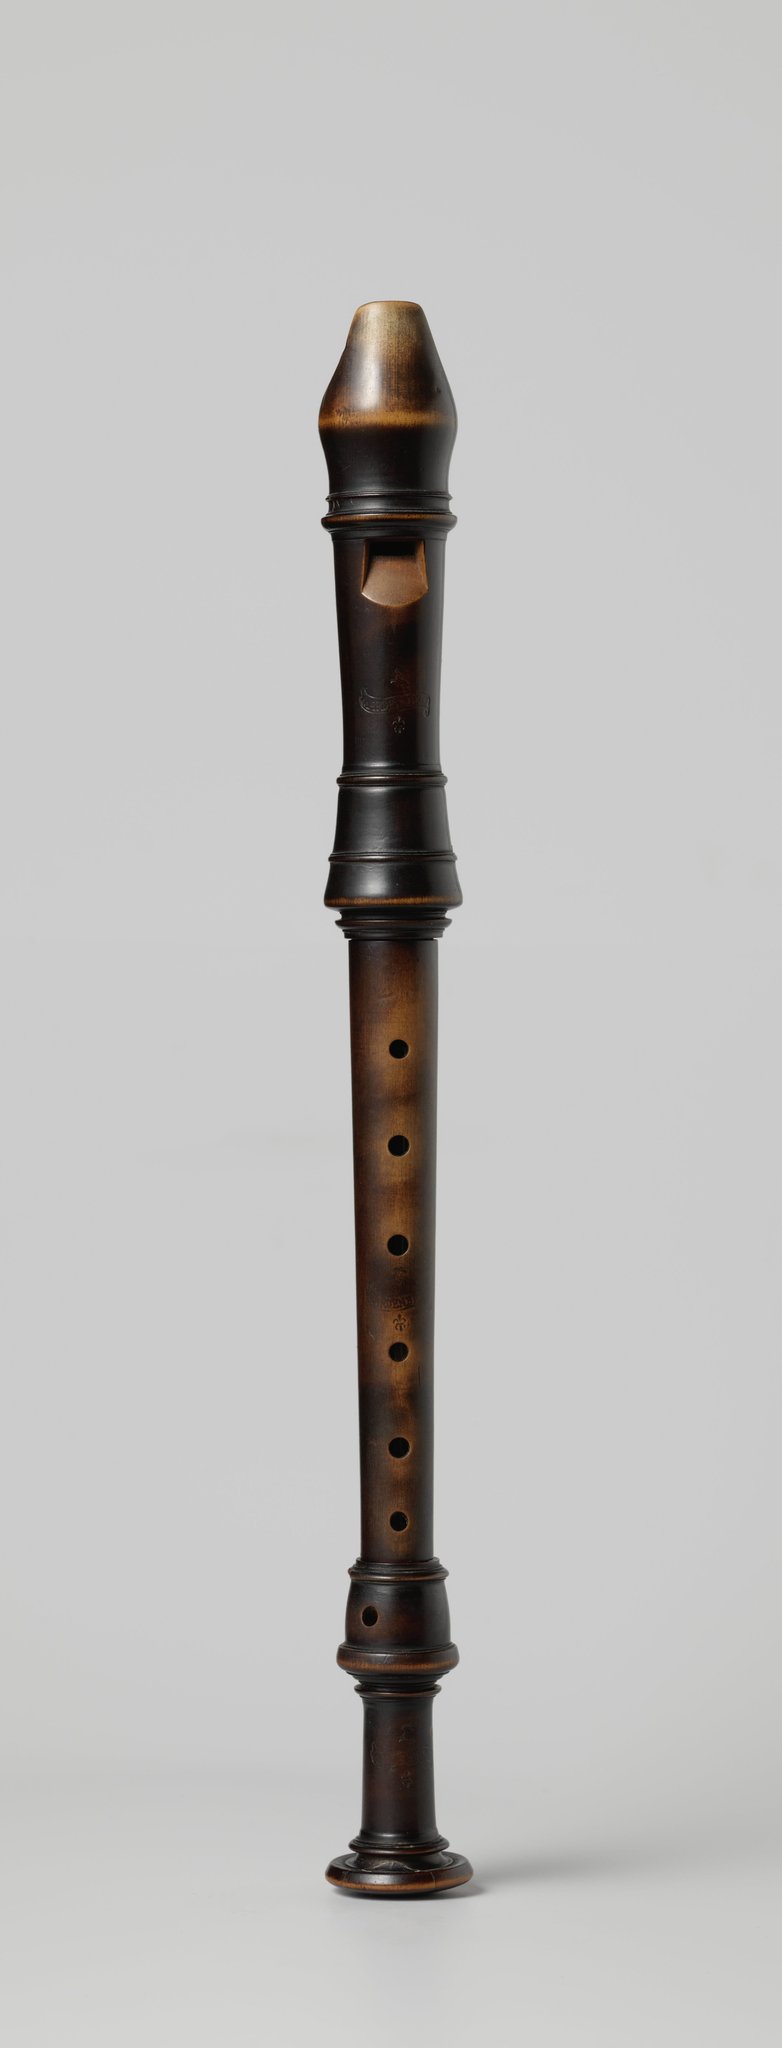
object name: flute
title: Descant recorder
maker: abraham van aardenberg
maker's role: musical instrument maker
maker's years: 1672-1717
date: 1700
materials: wood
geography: amsterdam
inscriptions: stamp, on the head, main and foot joint, stamped: ‘AARDENBERG’ [a jumping deer]/ AARDENBERG [in scroll with a small ‘v‘ in the first A replaces the dash of that A]/ [a fleur-de-lis]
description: Sopraanblokfluit, gemerkt op een banderolle AARDENBERG, waarboven een hert en waaronder een lelie.